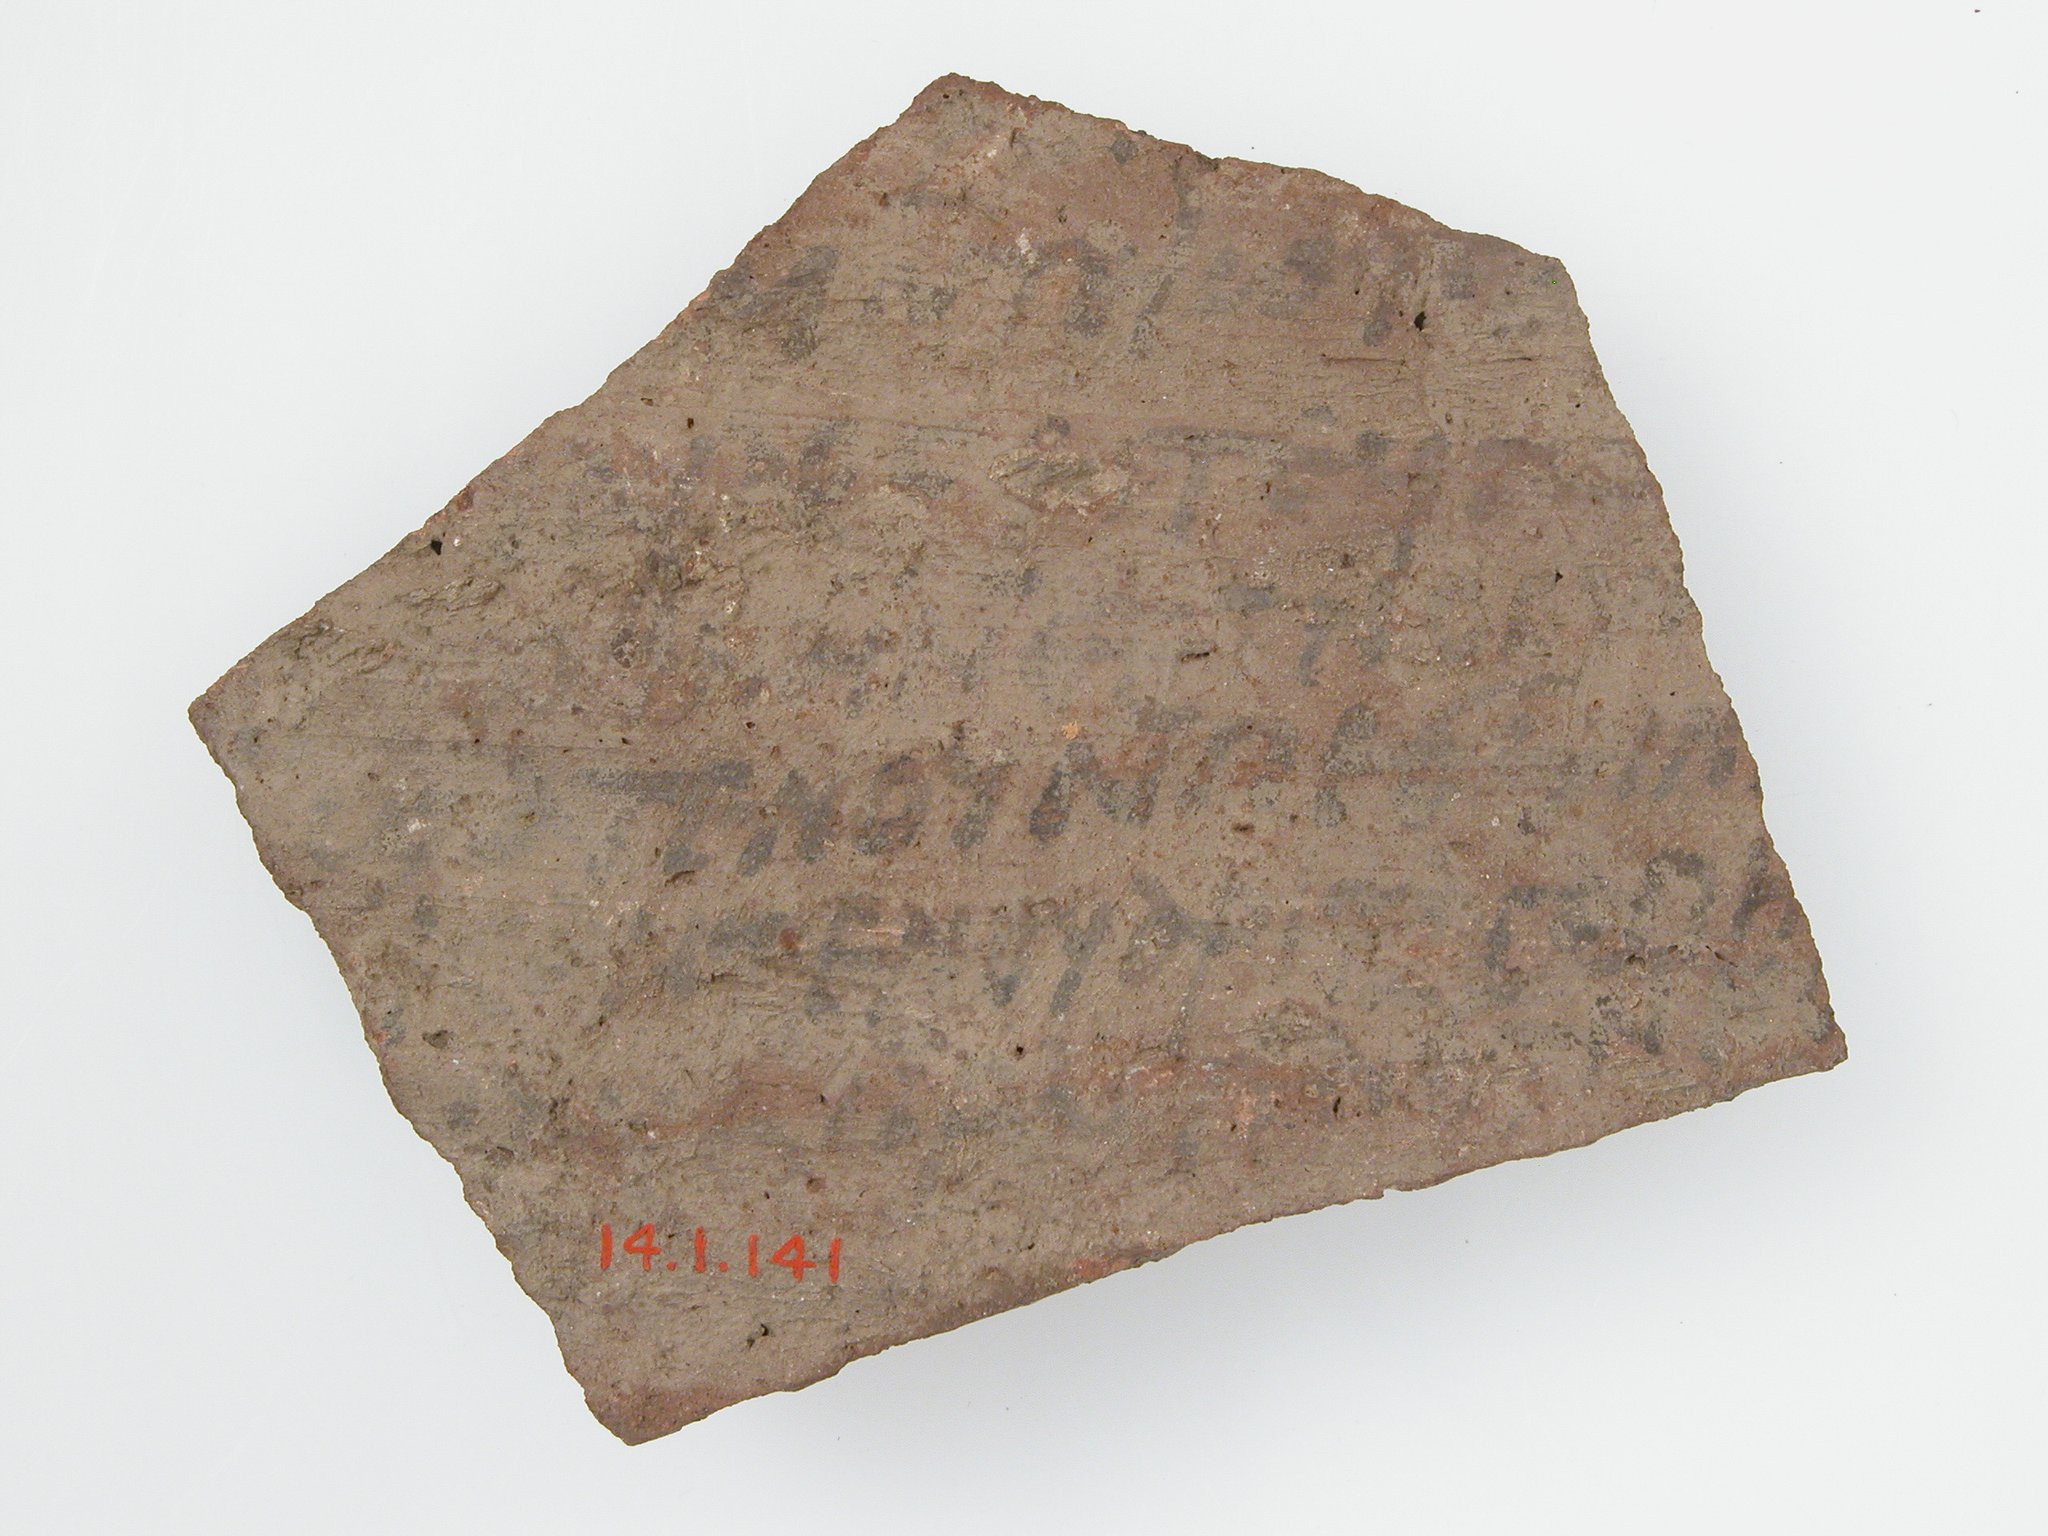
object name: ostrakon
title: Ostrakon with a Letter from Christodorus (?) to Psan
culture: coptic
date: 600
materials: ink, pottery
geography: egypt